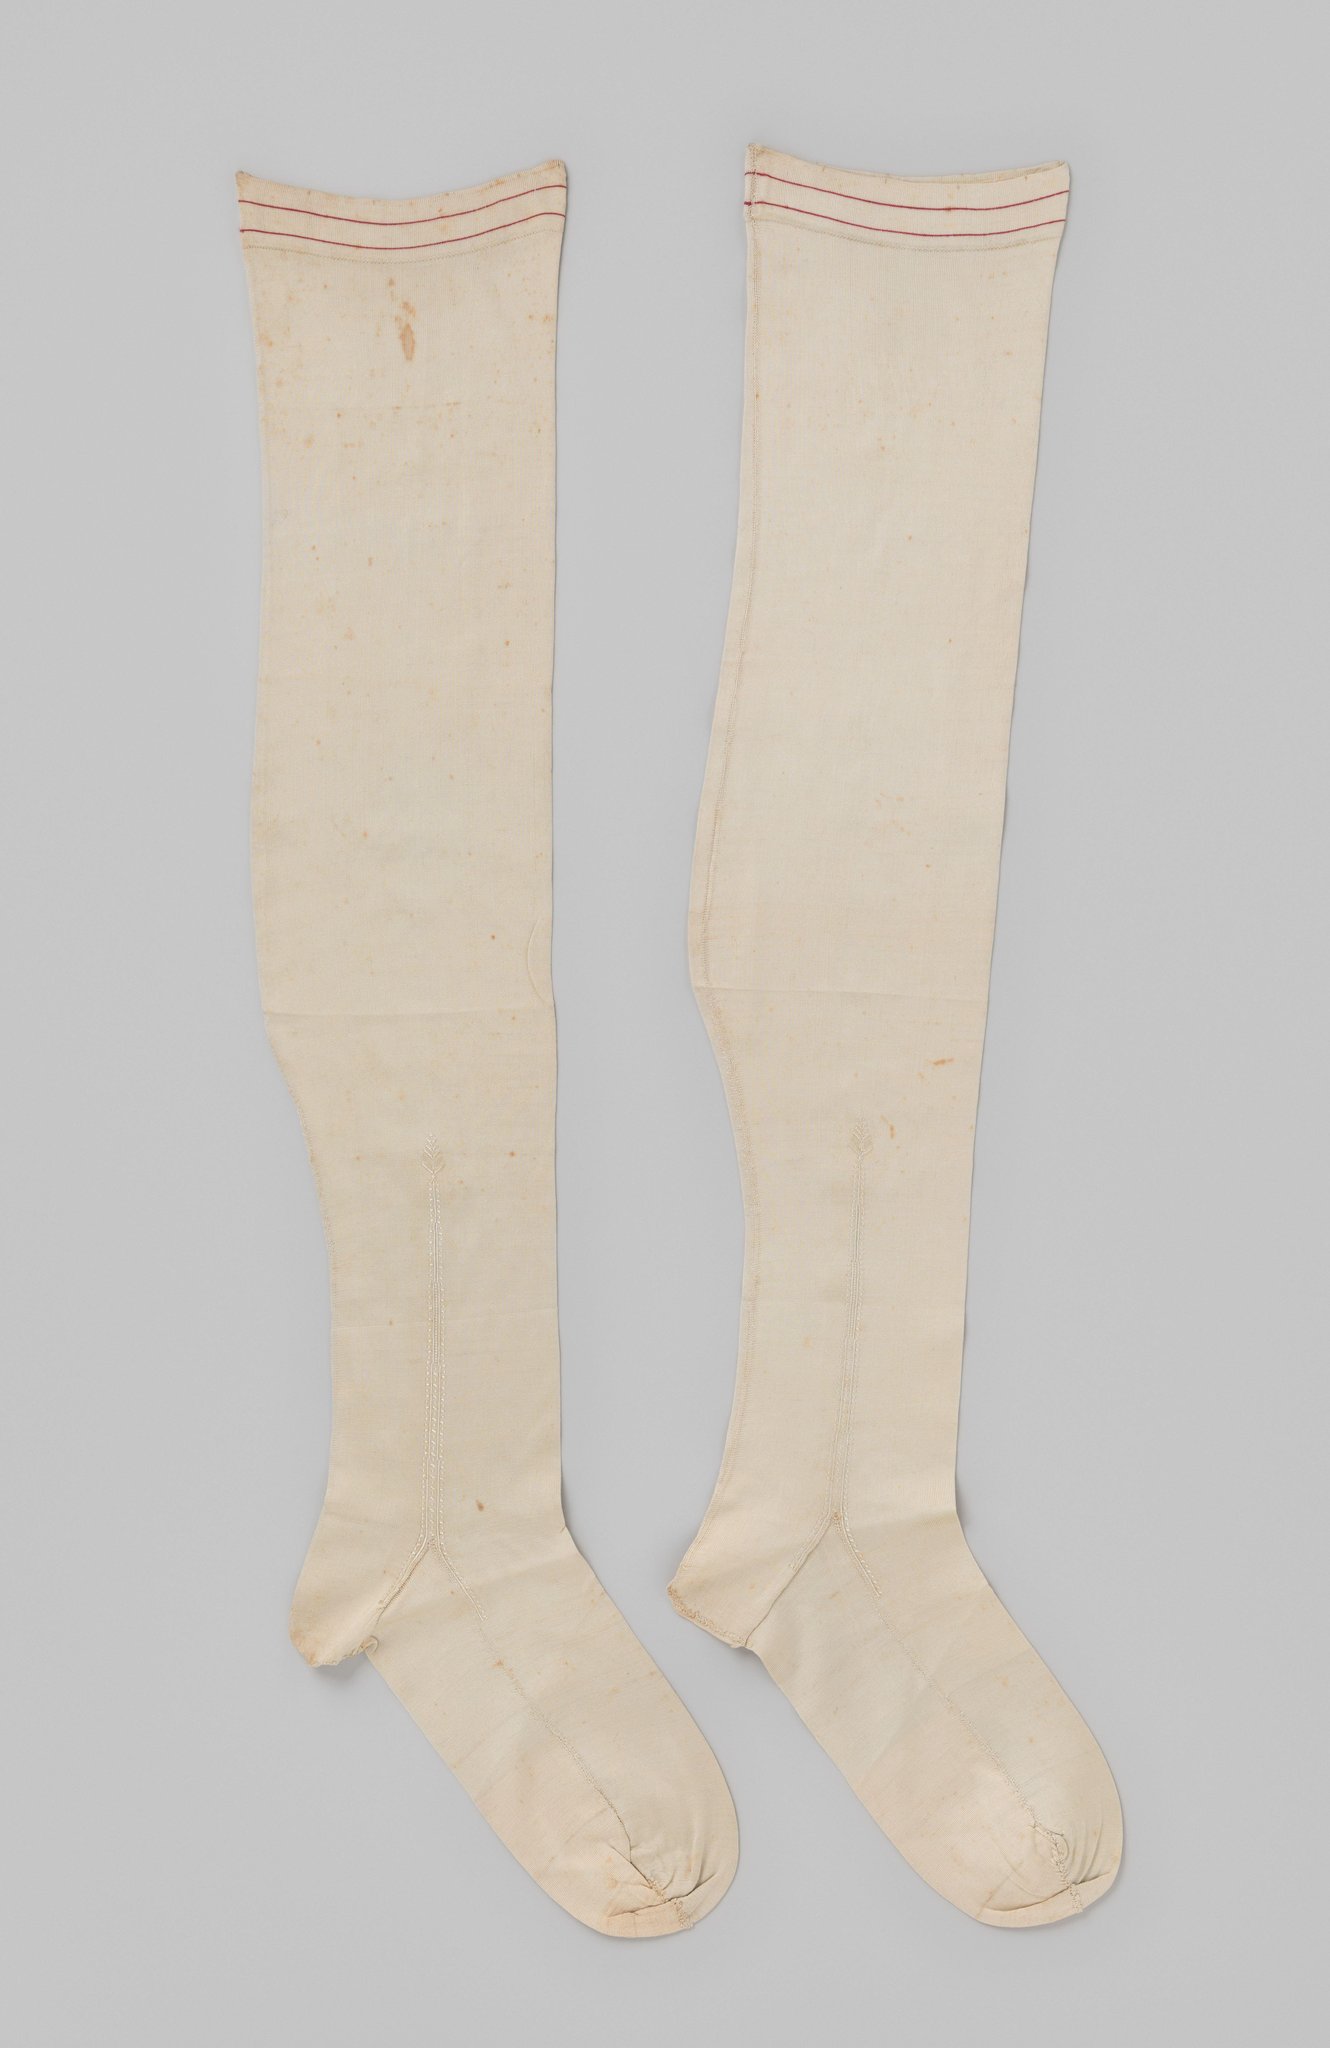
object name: stocking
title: Kous van licht turquoise zijden tricot met pijlen op de klinken en bovenaan twee meegebreide paarse strepen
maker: Anonymous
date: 1700-1800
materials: silk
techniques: knitting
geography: netherlands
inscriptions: initials: ‘L.P.O’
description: Kous van licht turquoise zijden tricot met pijlen op de klinken. Naad middenachter. Bovenaan twee meegebreide paarse strepen, waartussen L.P.O.